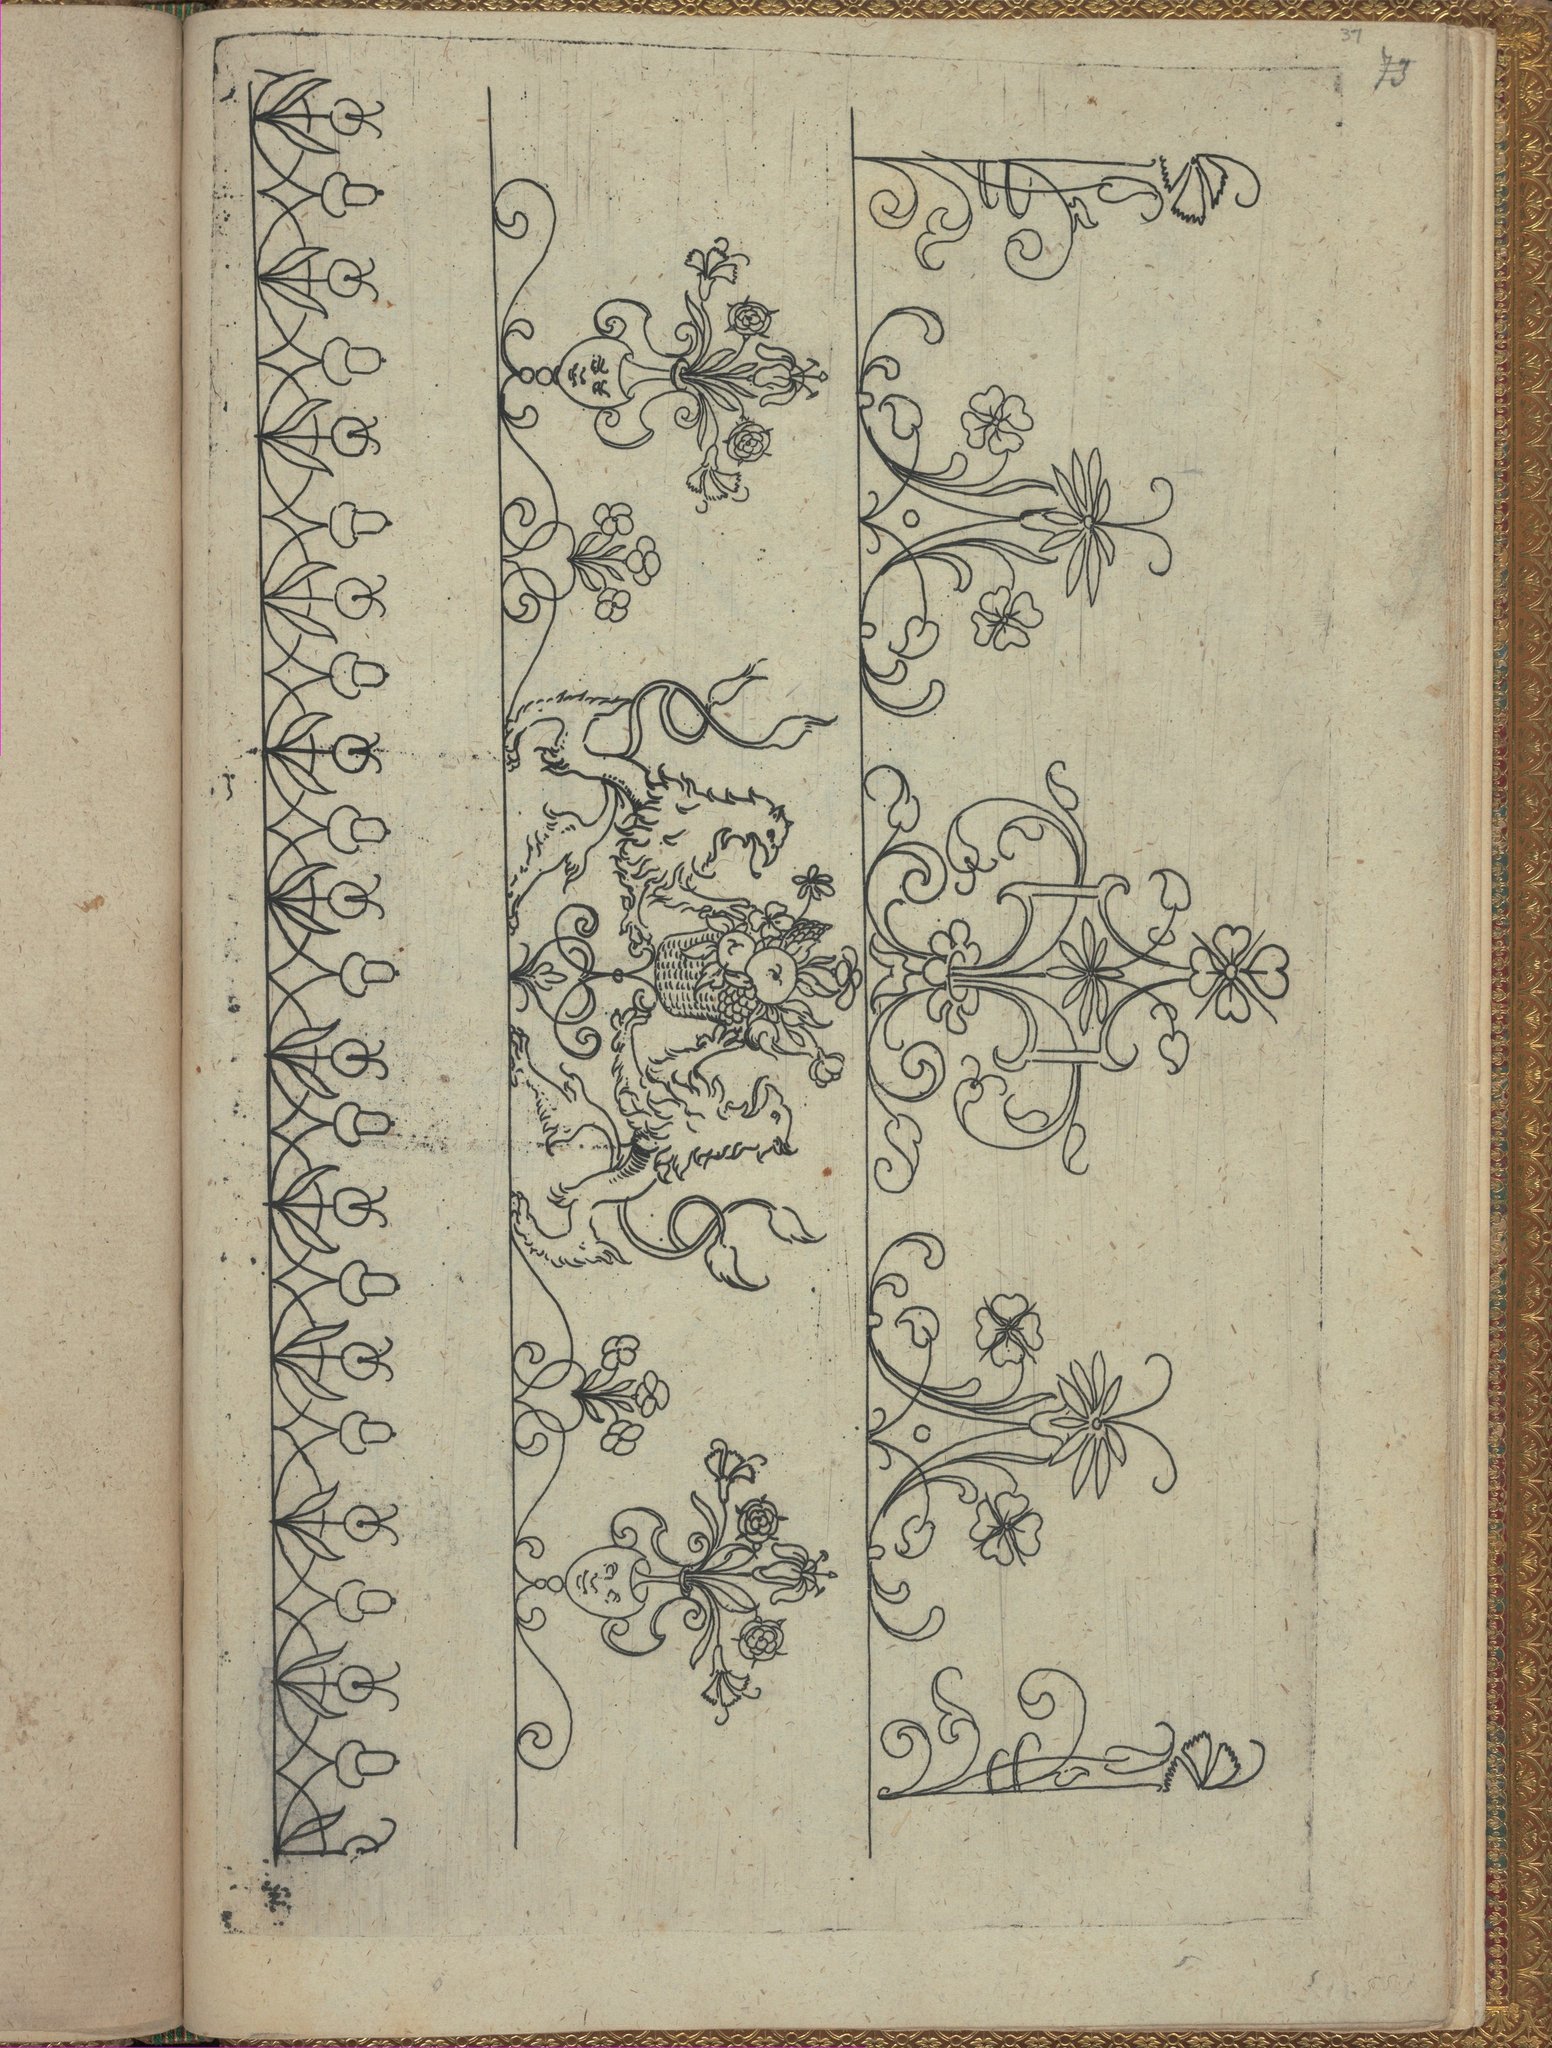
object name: book print ornament architecture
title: New Modelbüch (Page 37r)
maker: andreas bretschneider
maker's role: designer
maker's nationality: german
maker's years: 1573-1645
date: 1615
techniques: etching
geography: germany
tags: flowers,coat of arms